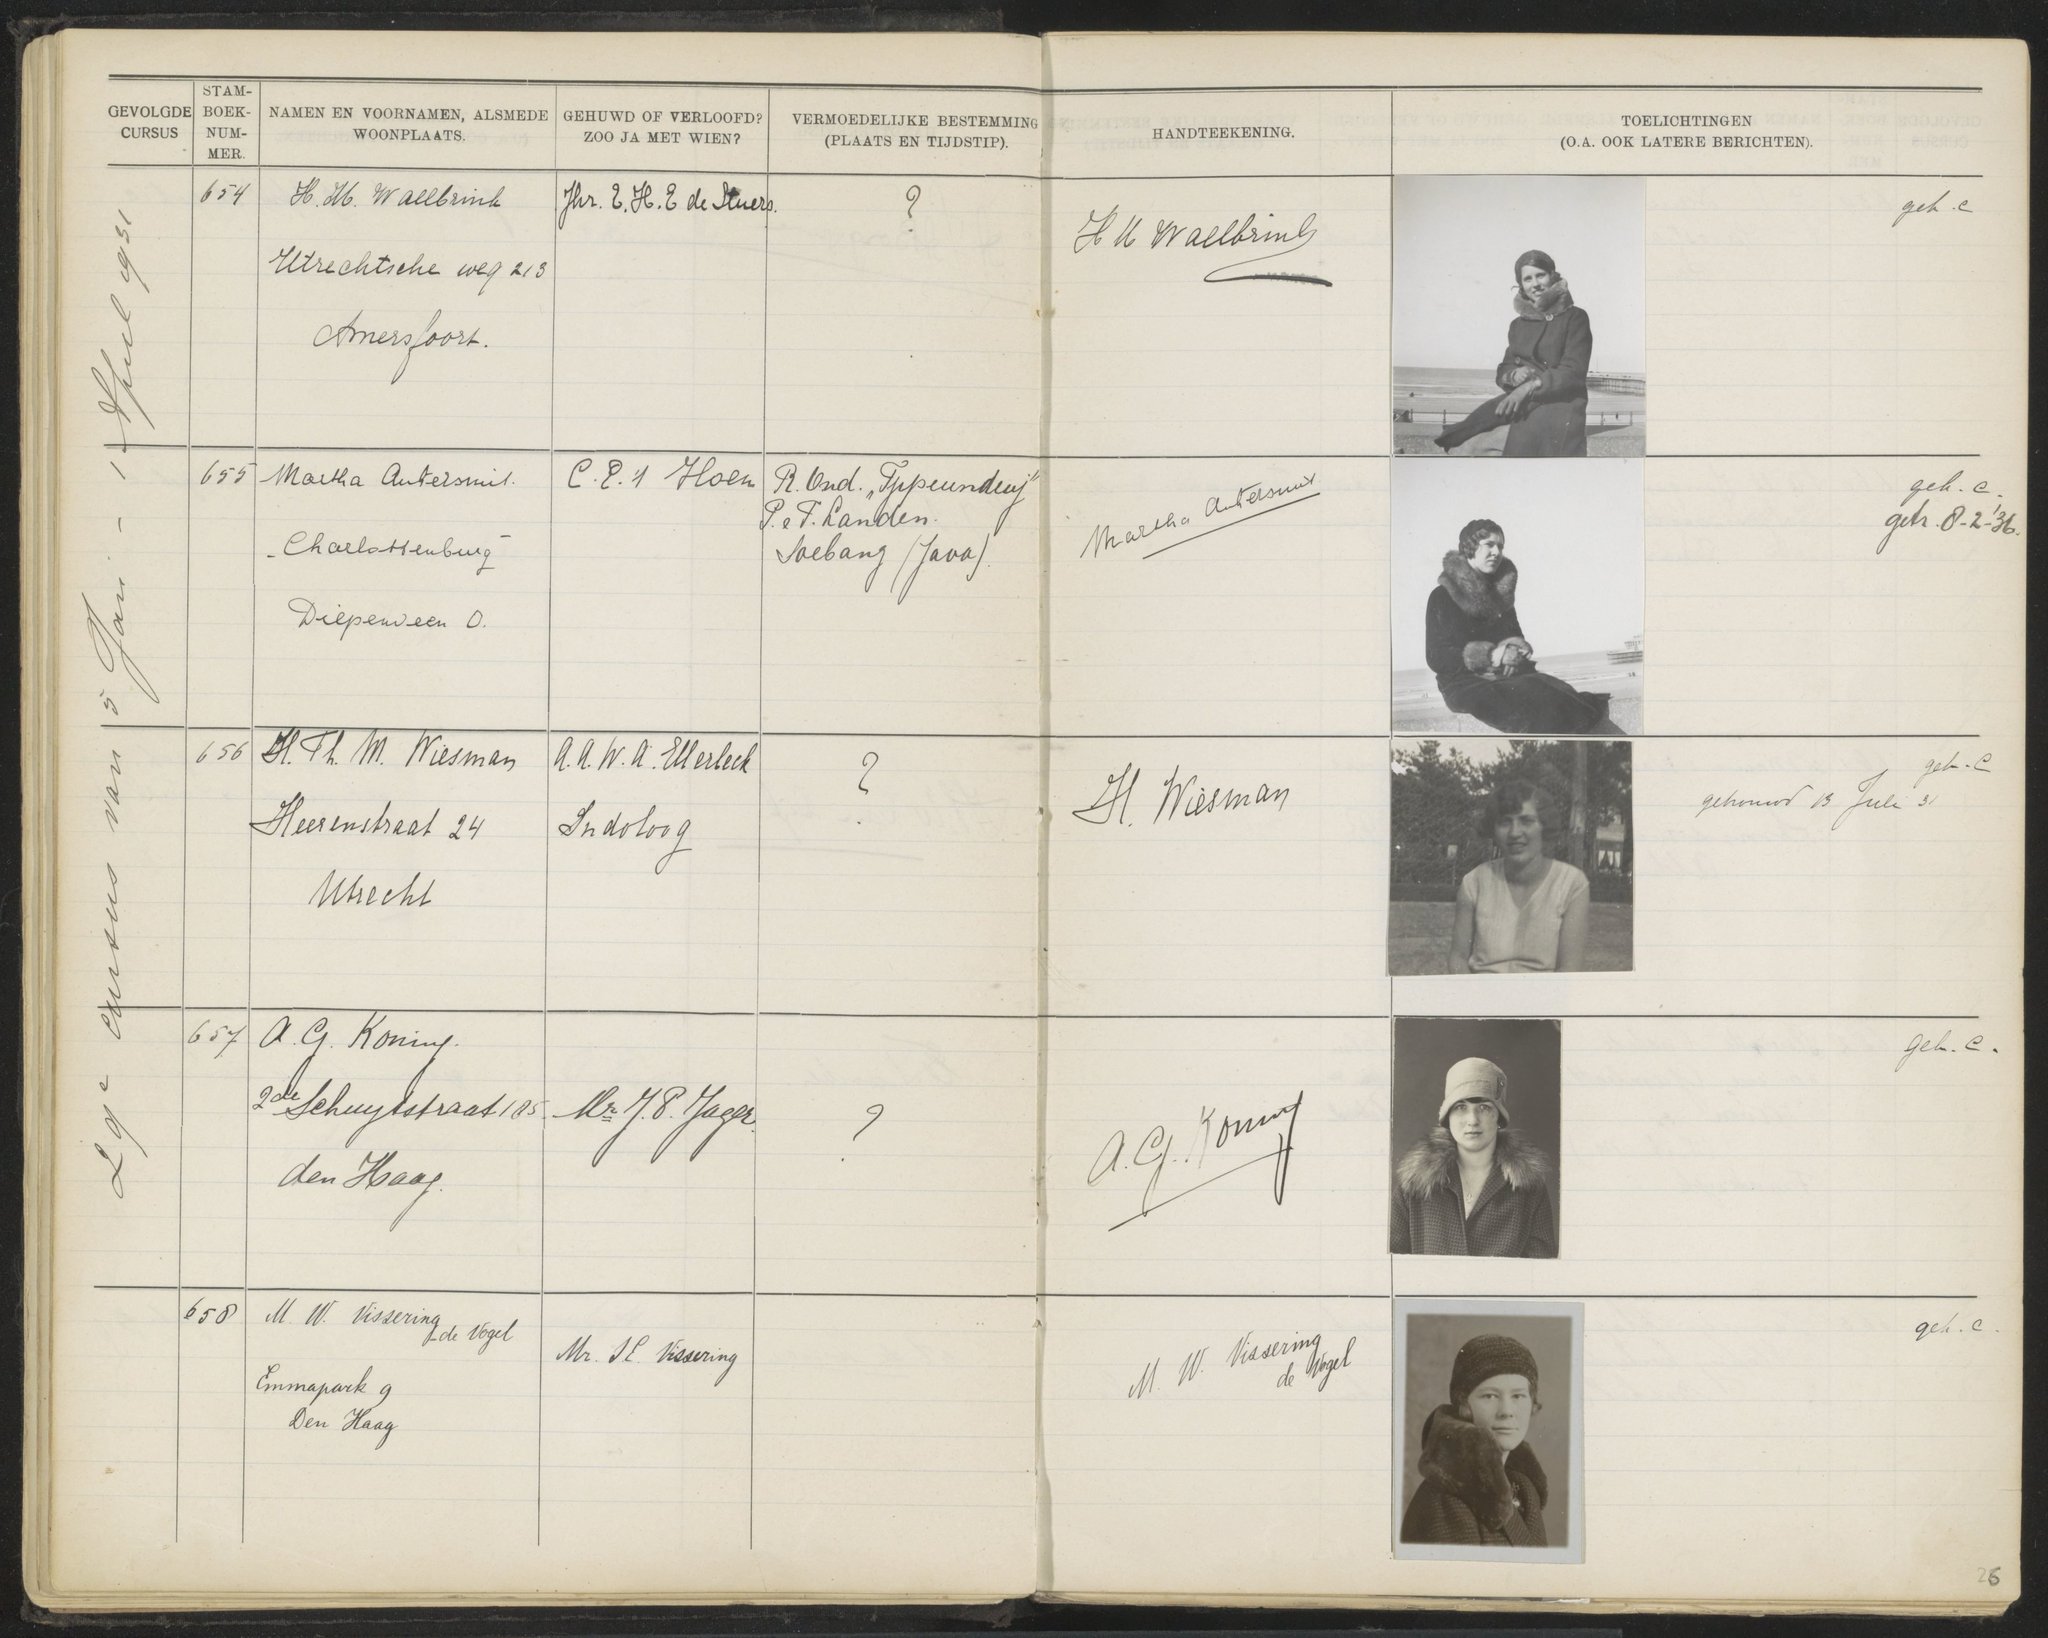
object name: photograph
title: Blad 26 uit Stamboek van de leerlingen der Koloniale School voor Meisjes en Vrouwen te 's-Gravenhage deel II (1930-1949)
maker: Anonymous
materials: paper, photographic support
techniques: photography, printing, writing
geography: the hague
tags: further education (+ pupil), further education, the hague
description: Twee pagina's met gegevens van de deelnemers aan de 29e driemaandelijkse cursus van 5 januari tot en met 1 april 1931, stamboeknummers 654 tot en met 658. Onderdeel van Stamboek van de leerlingen der Koloniale School voor Meisjes en Vrouwen te 's-Gravenhage deel II (1930-1949).